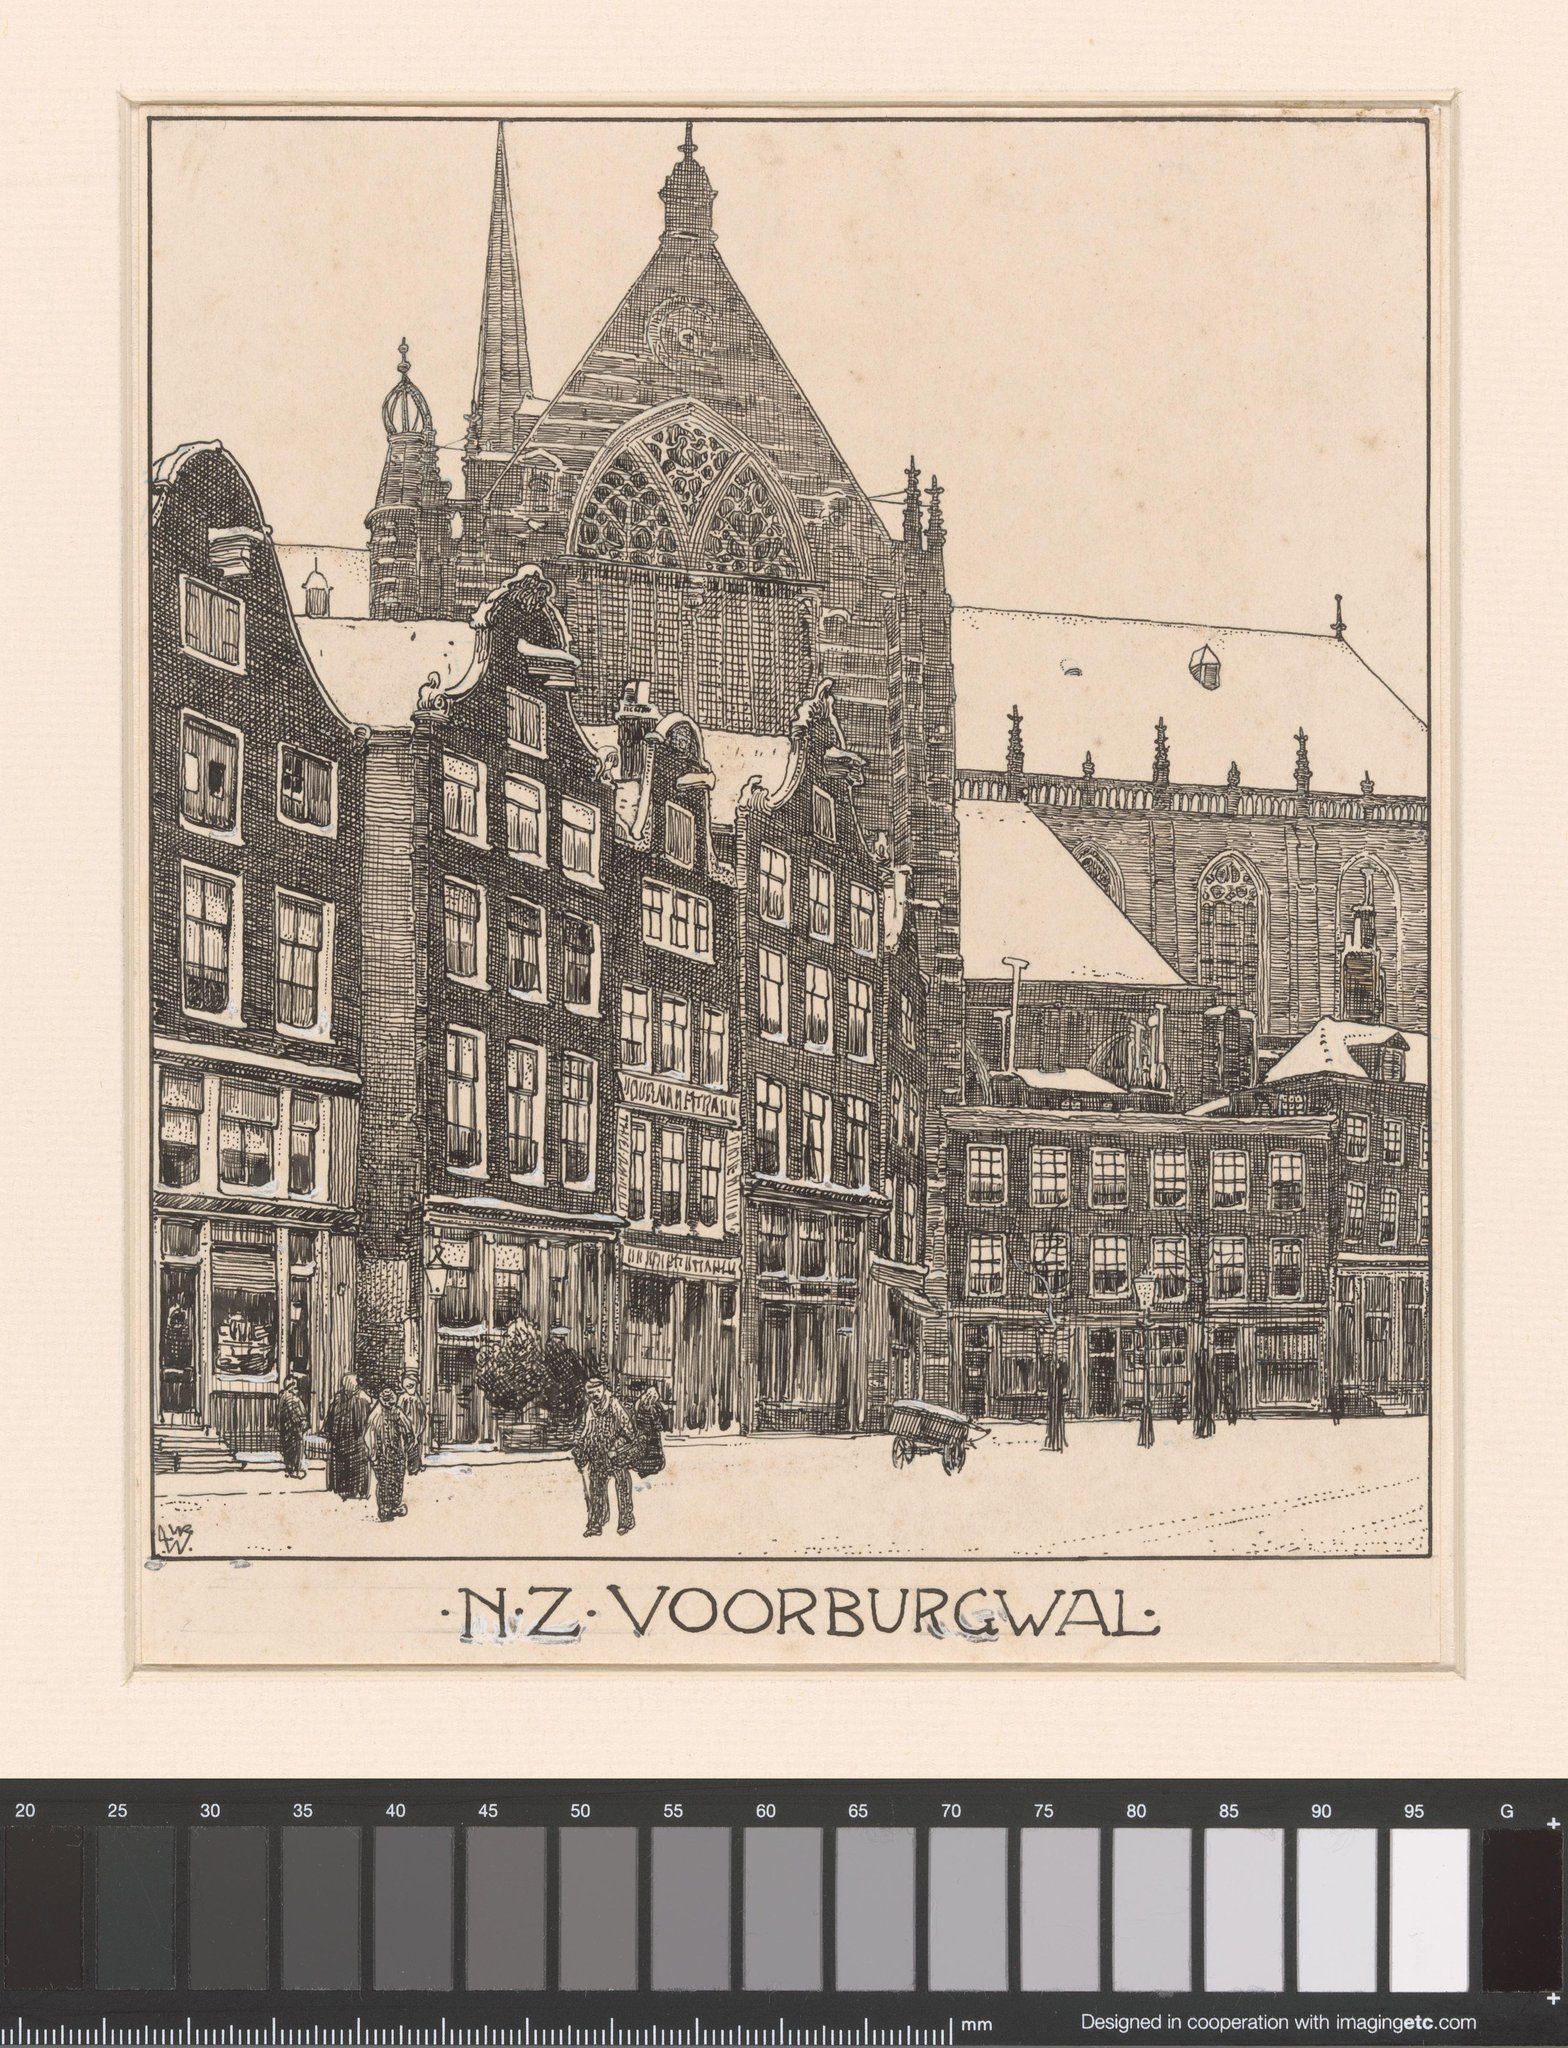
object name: drawing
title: Nieuwe Zijds Voorburgwal te Amsterdam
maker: willem wenckebach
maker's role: designer, draughtsman, painter, print maker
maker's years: 1860-1937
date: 1870-1926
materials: paint, ink, paper, pencil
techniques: pen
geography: amsterdam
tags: street